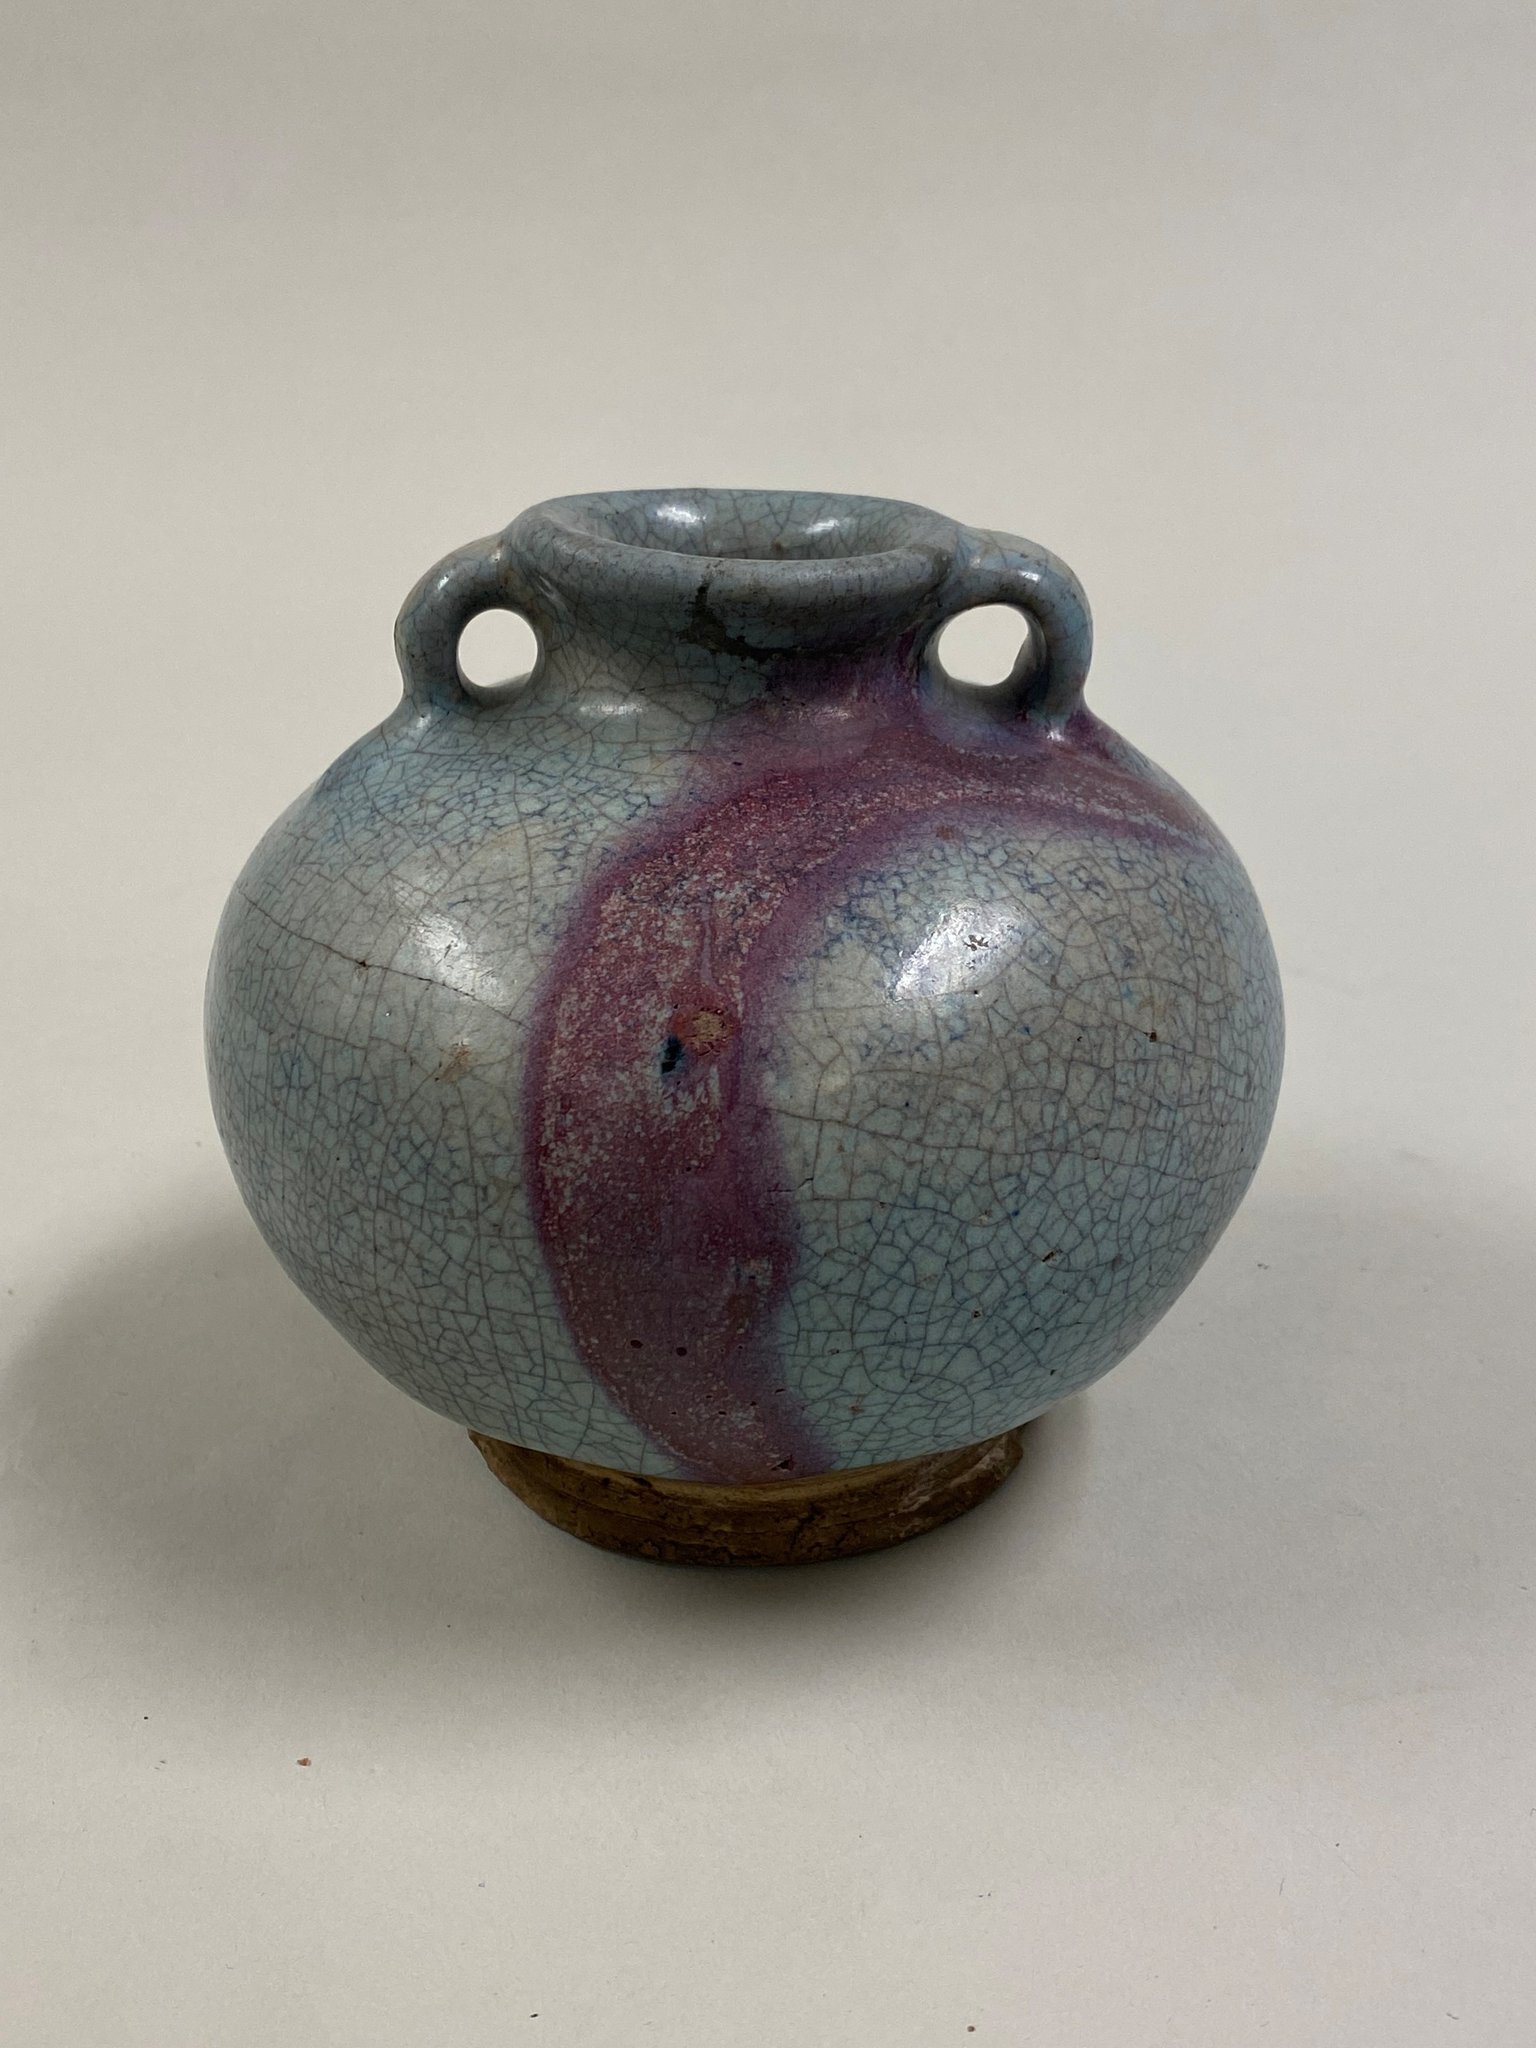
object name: jar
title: Jar with two lugs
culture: chinese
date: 1201-1300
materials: glaze, stoneware